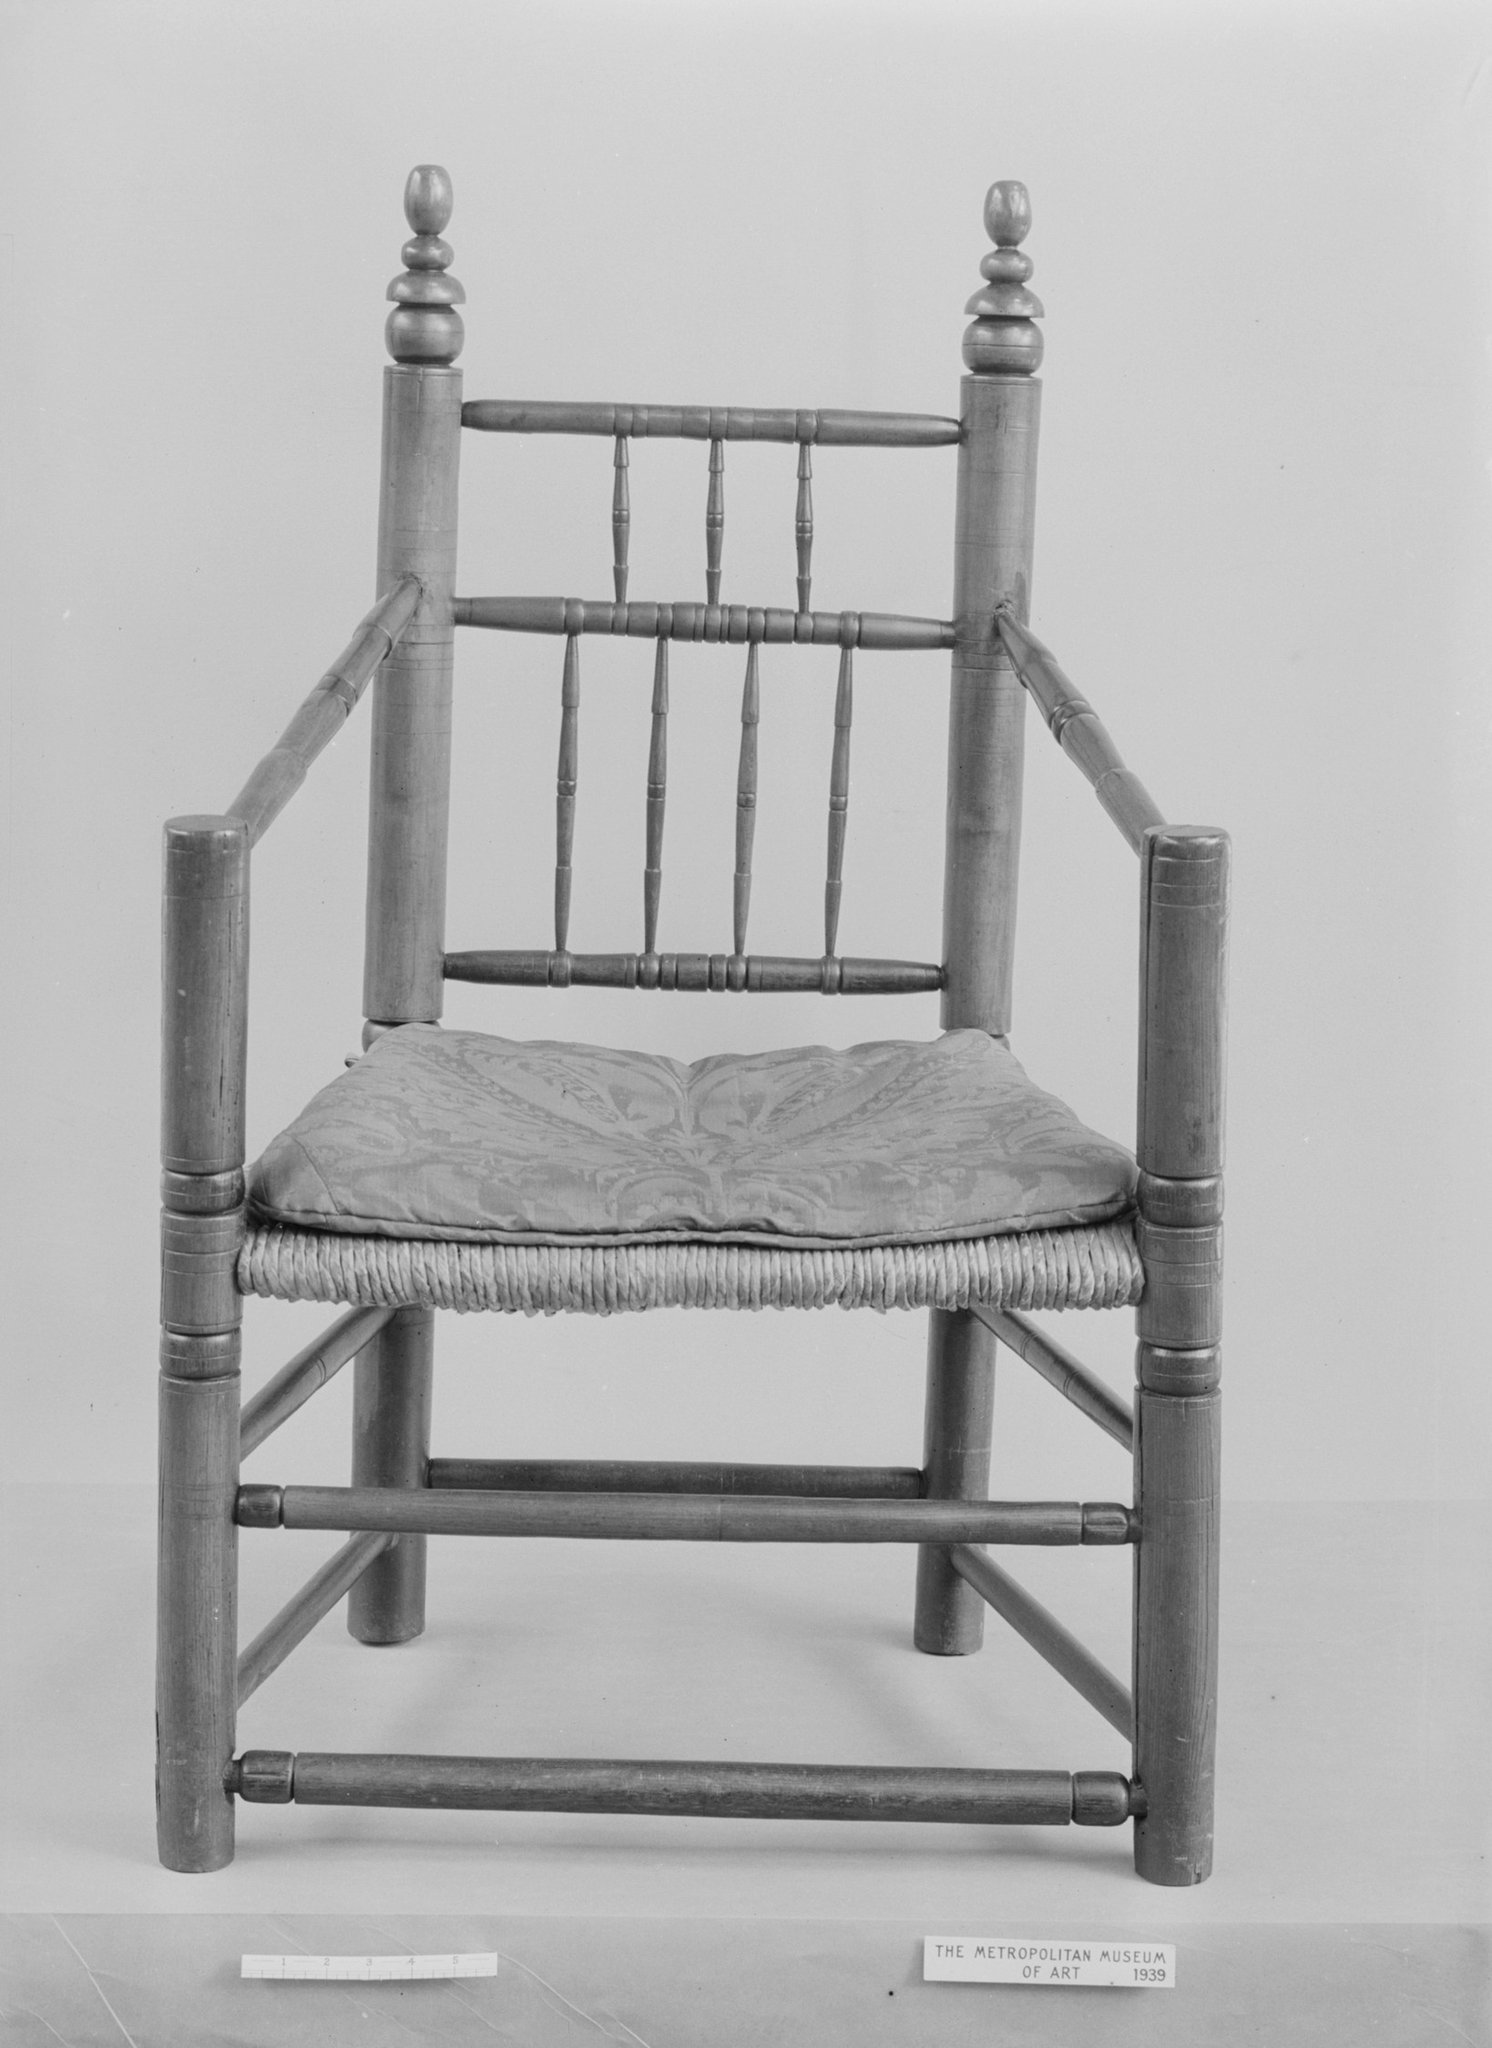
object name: armchair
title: Turned Armchair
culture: american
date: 1650-1700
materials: wood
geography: united states